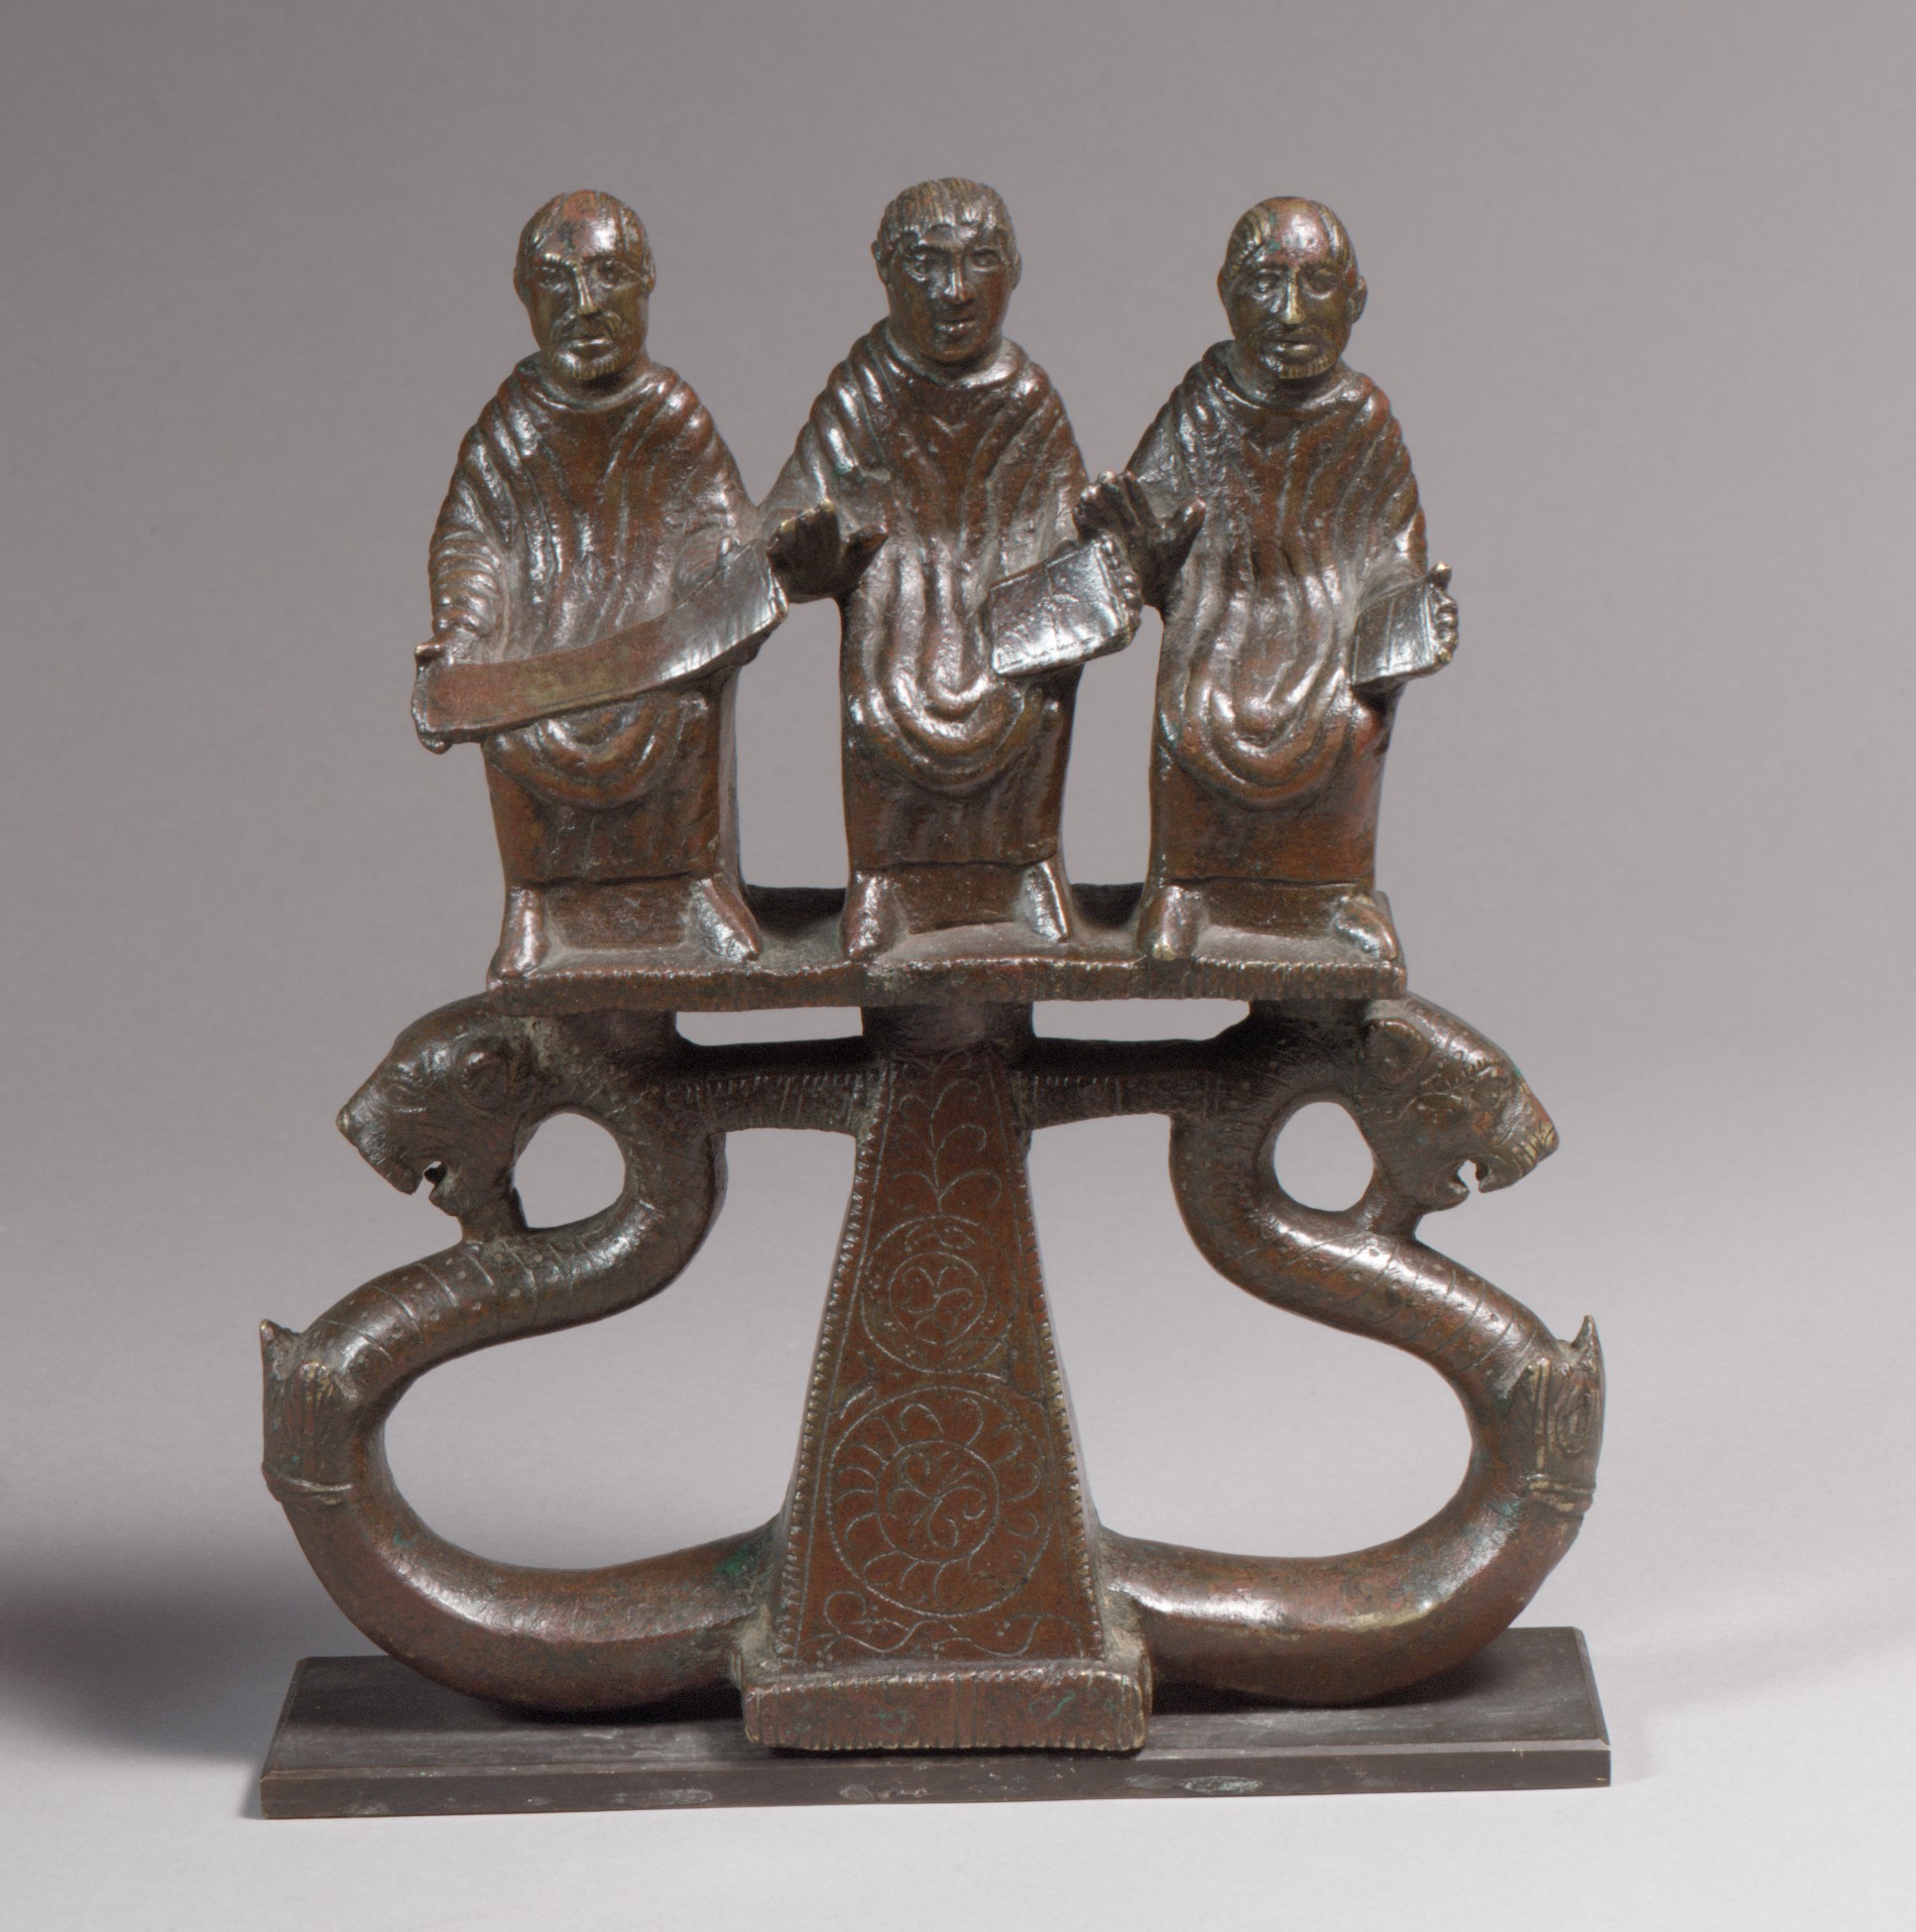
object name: chariot mount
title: Chariot Mount with Three Figures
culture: late roman or byzantine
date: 300-500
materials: copper alloy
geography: gaul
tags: men